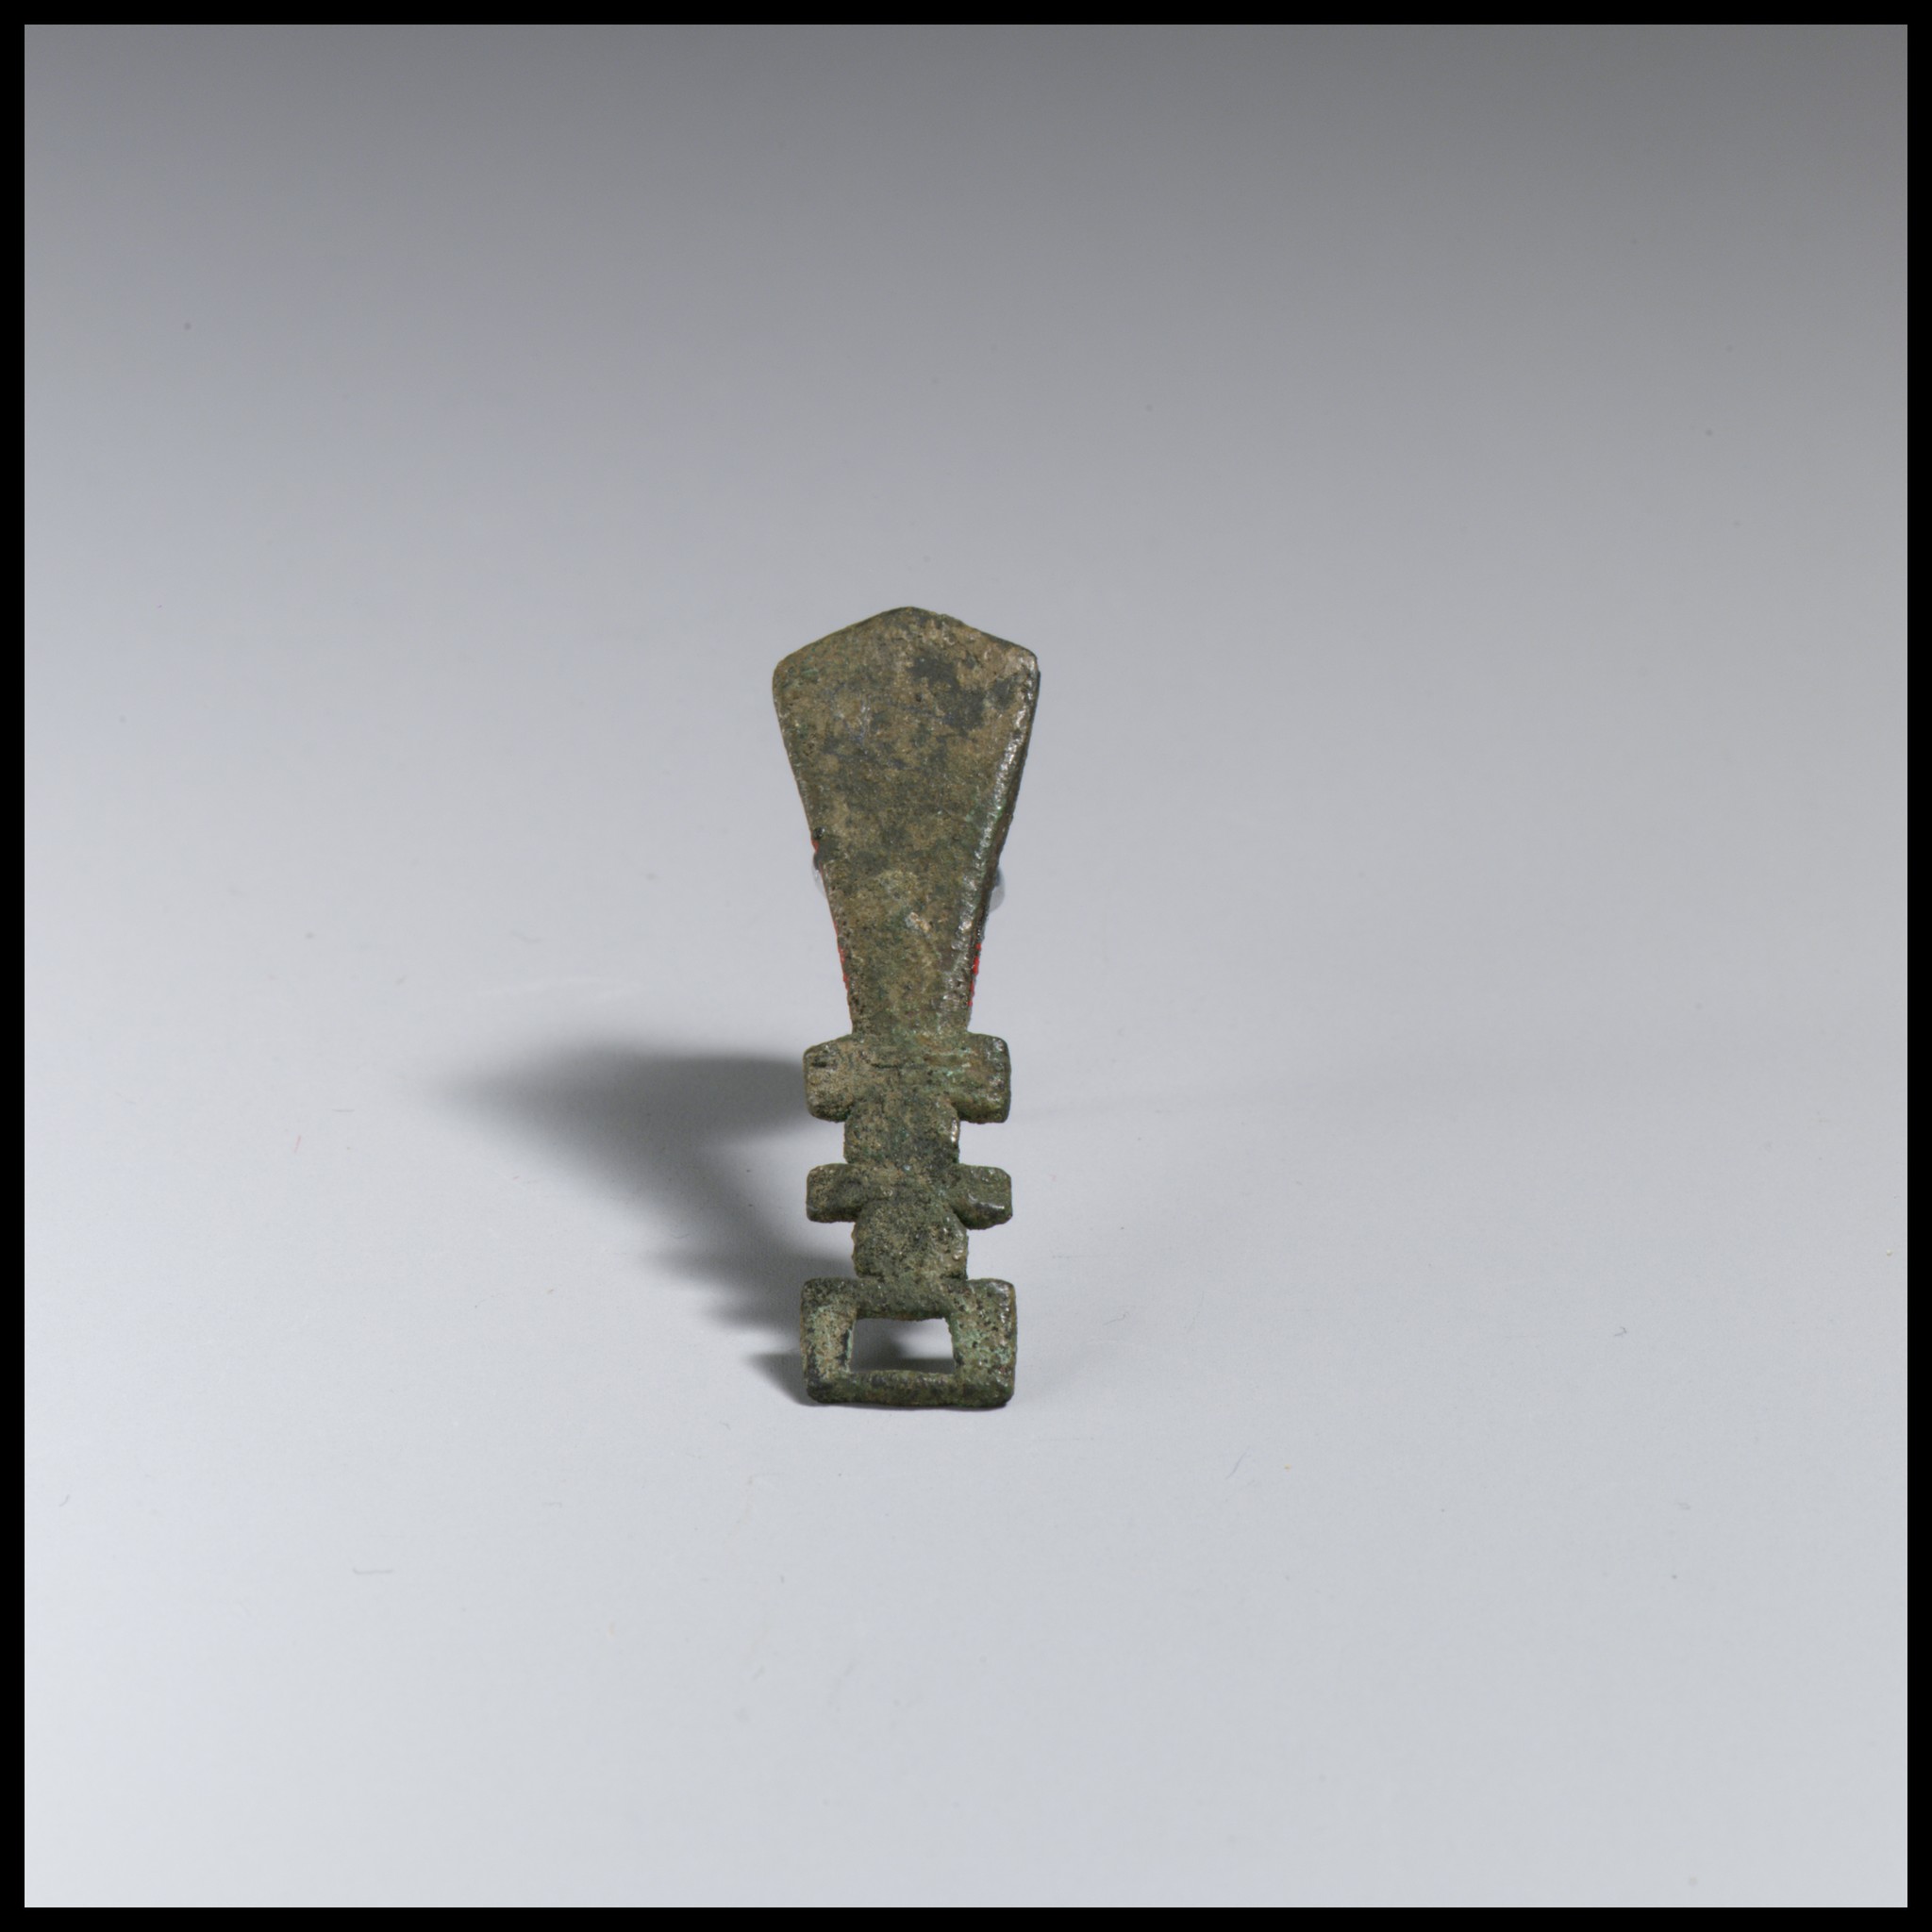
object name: buckle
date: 7000 BCE-330 CE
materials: bronze